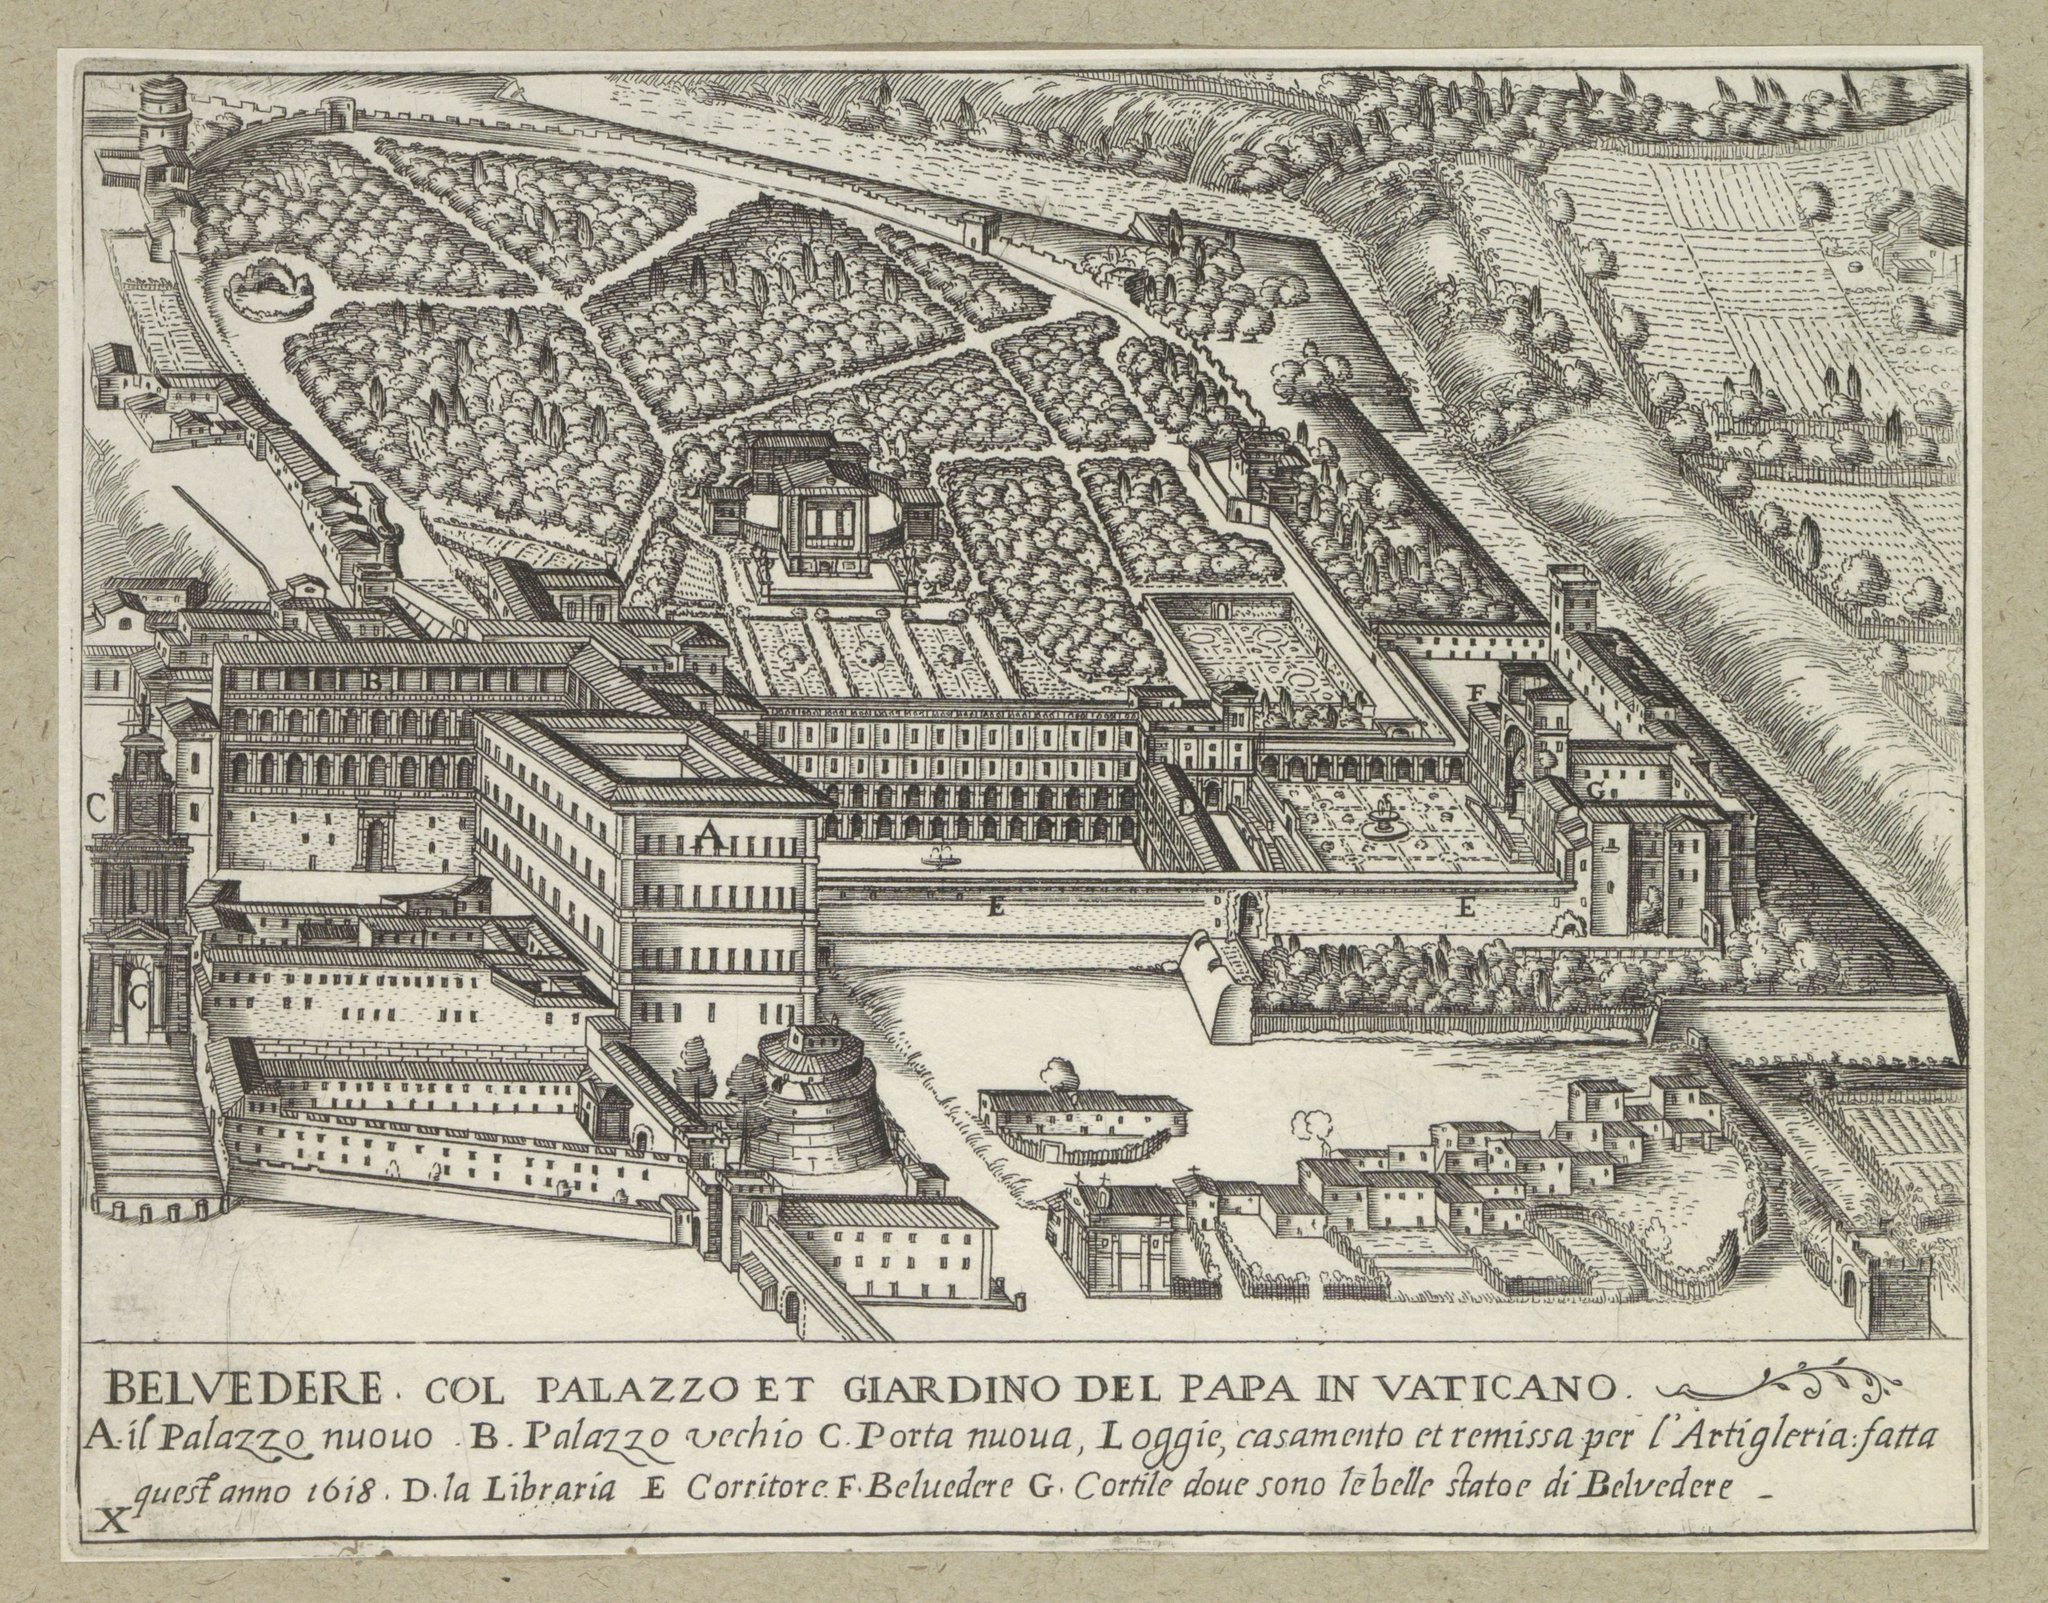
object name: album leaf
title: Belvedere col palazzo et giardino del Papa in Vaticano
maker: giovanni domenico de rossi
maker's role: print maker, publisher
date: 1623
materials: paper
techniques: engraving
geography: rome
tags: garden, palace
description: Deze prent maakt deel uit van een reeks van acht prenten van paleizen en tuinen in Rome.